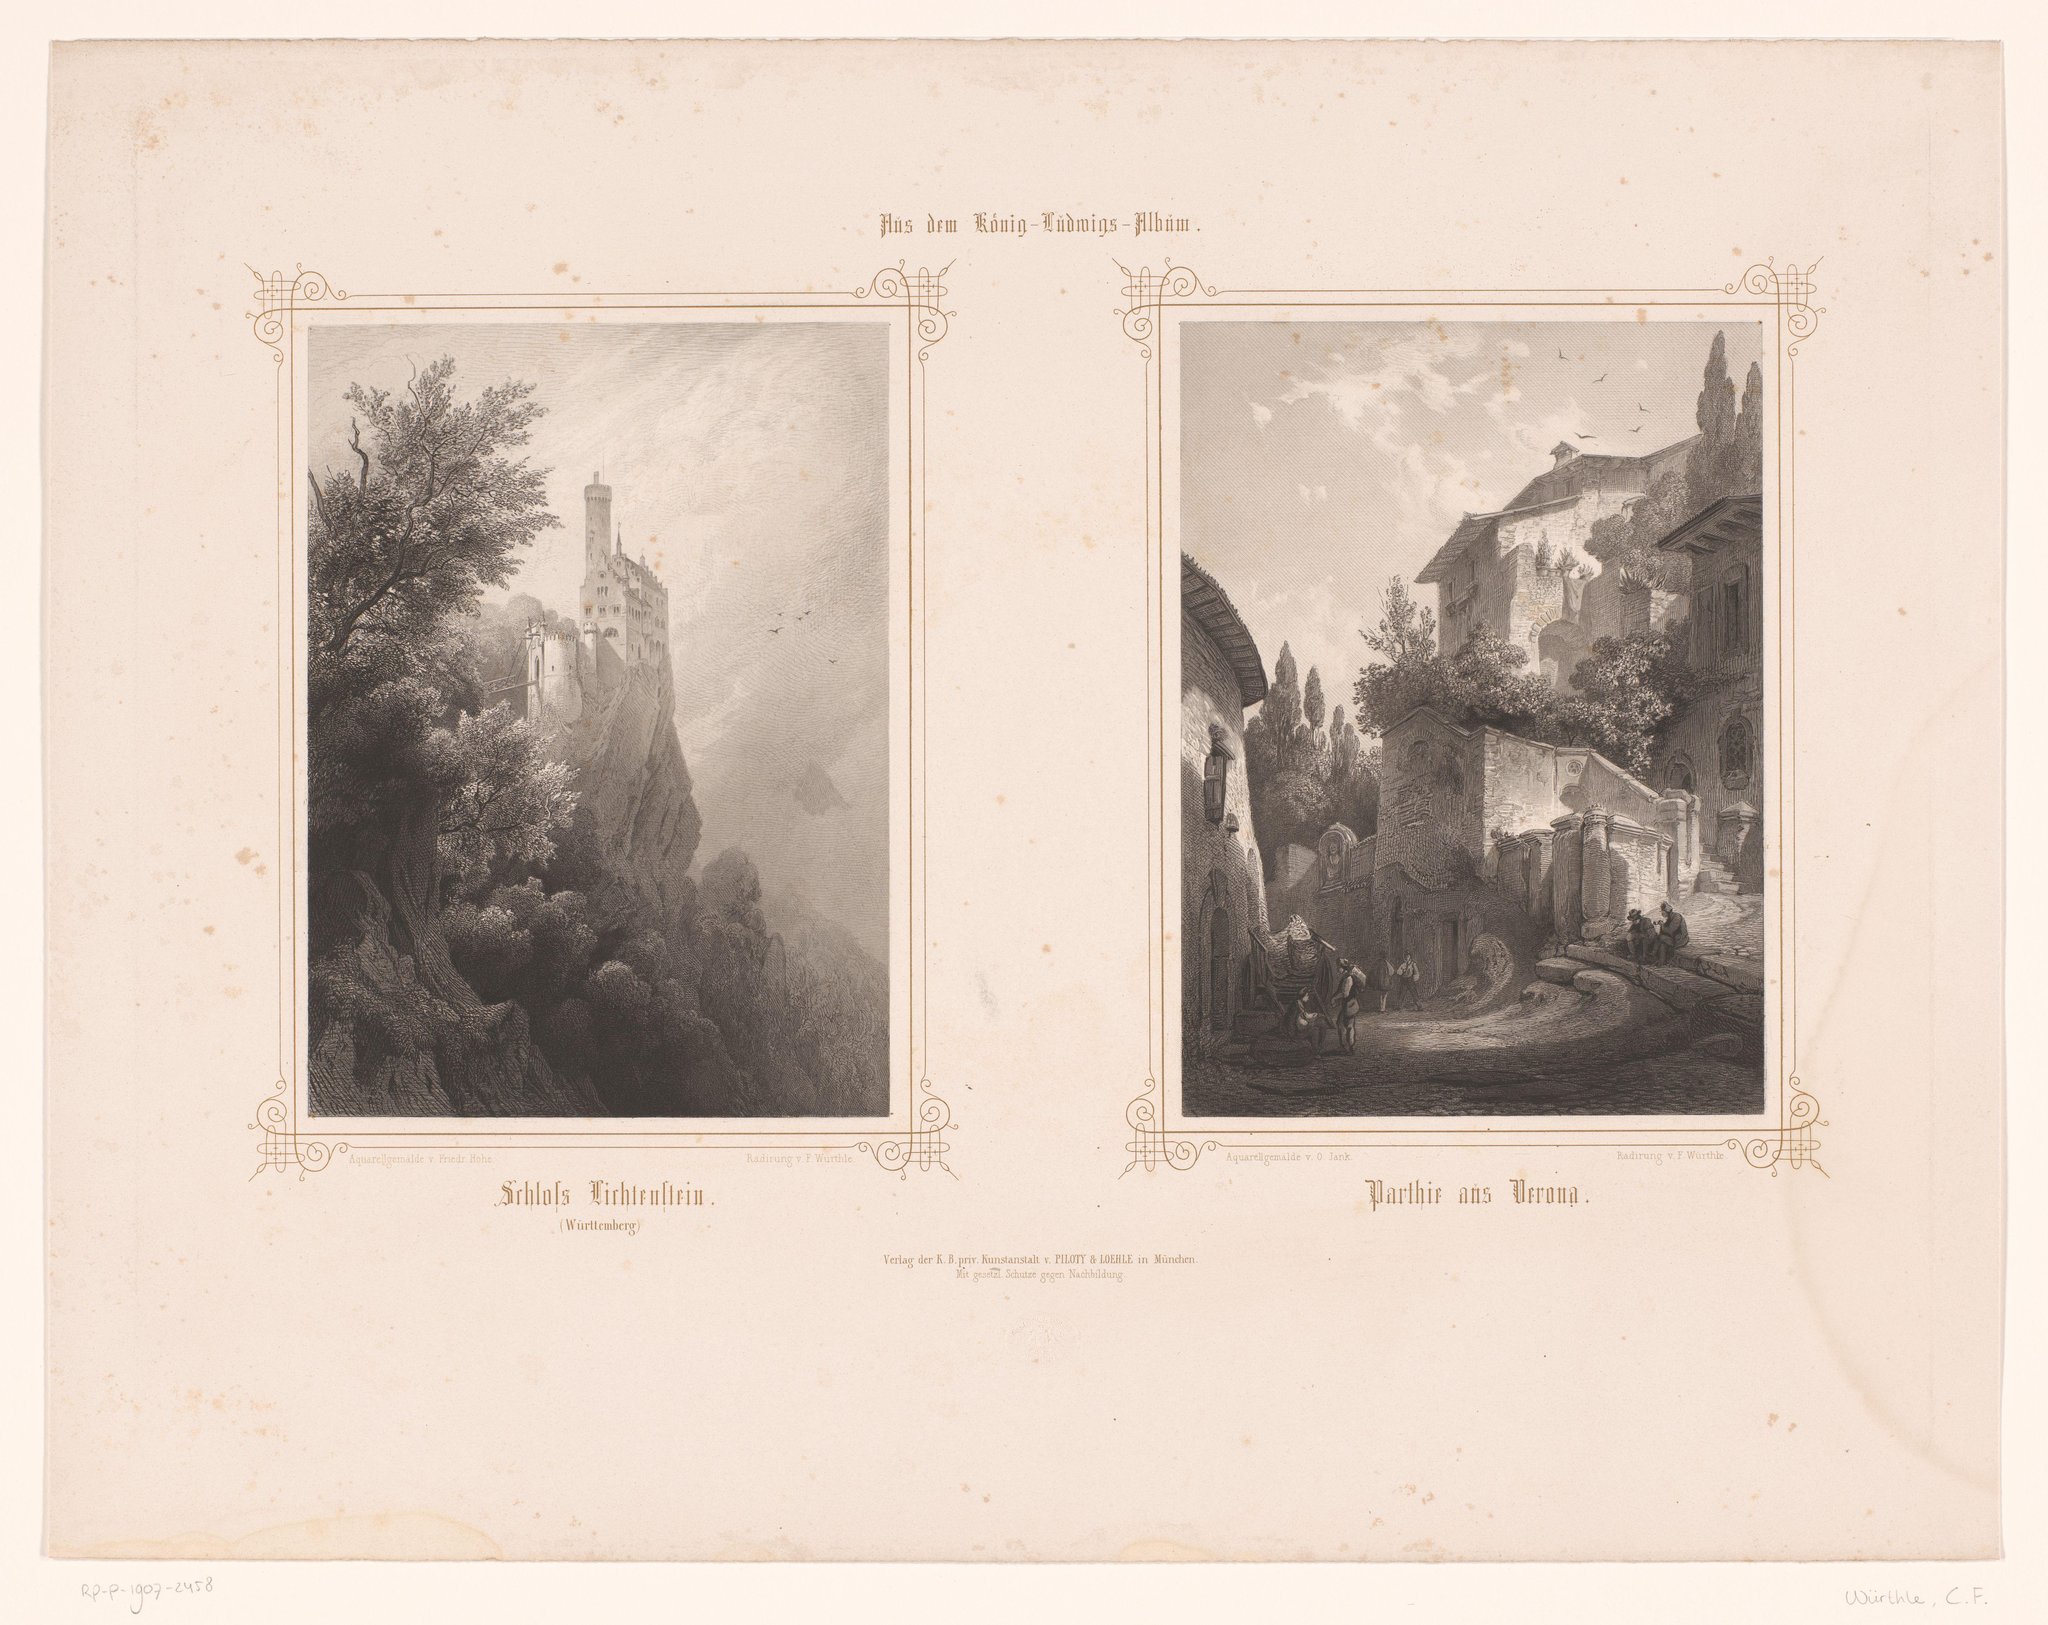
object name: print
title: Schloss Lichtenstein / Parthie aus Verona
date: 1850-1859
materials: paper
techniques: lithograph, engraving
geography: germany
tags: lodewijk i (koning van beieren), city-view in general; 'veduta', landscape with tower or castle, mountains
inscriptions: collector's mark: Lugt 2228, check stamp: ‘Piloty & Loehle München’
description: Prent afkomstig uit de serie 'Album Seiner Majestät des Königs Ludwig I. von Bayern', verschenen in verschillende afleveringen. De prenten gaan terug op het album dat Lodewijk I van Beieren op 9 oktober 1850 kreeg overhandigd van verschillende kunstenaars.